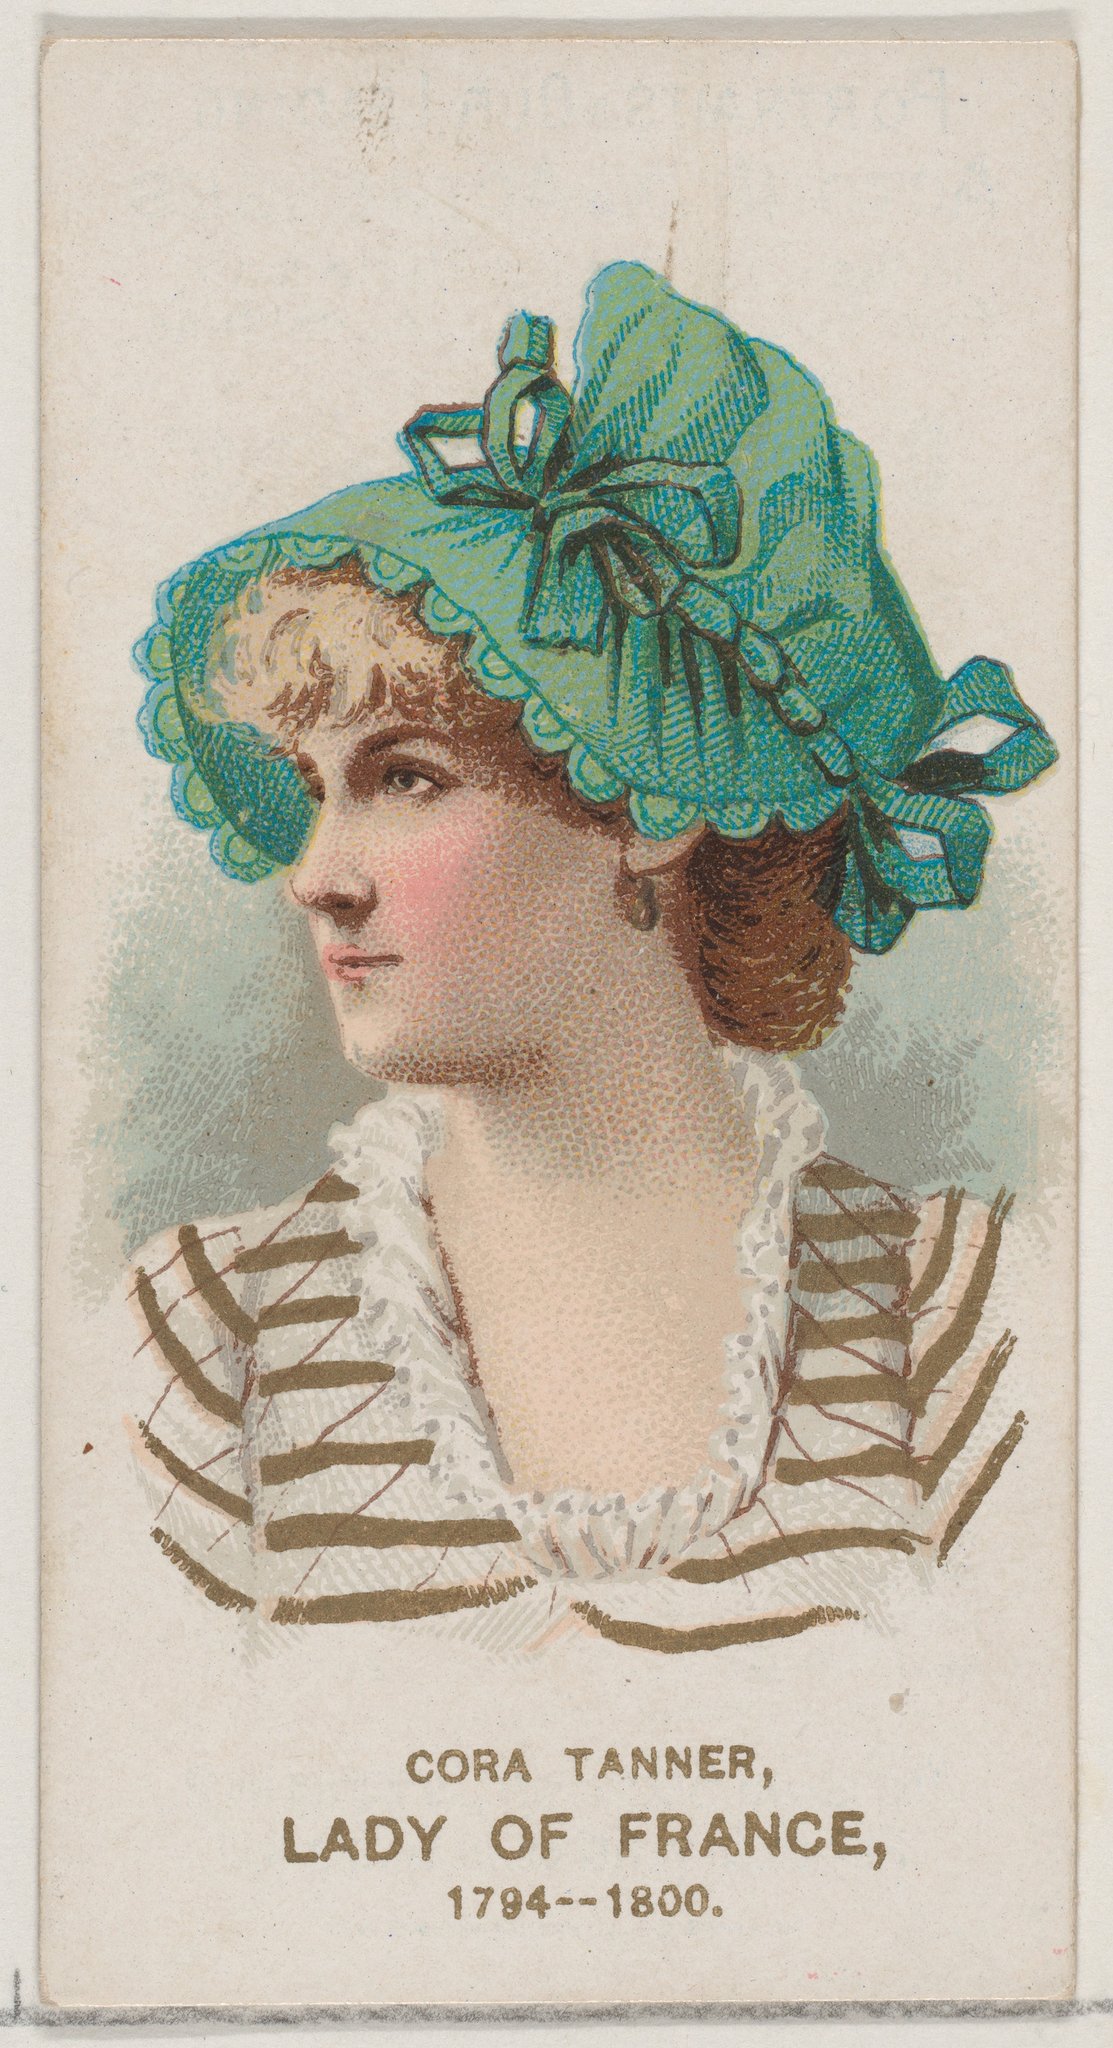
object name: print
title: Cora Tanner as a Lady of France, 1794-1800, from the set Actors and Actresses, Second Series (N71) for Duke brand cigarettes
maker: w. duke, sons & co.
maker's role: publisher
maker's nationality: american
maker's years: 1870-1920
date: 1888-1890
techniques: color lithograph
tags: women,actresses